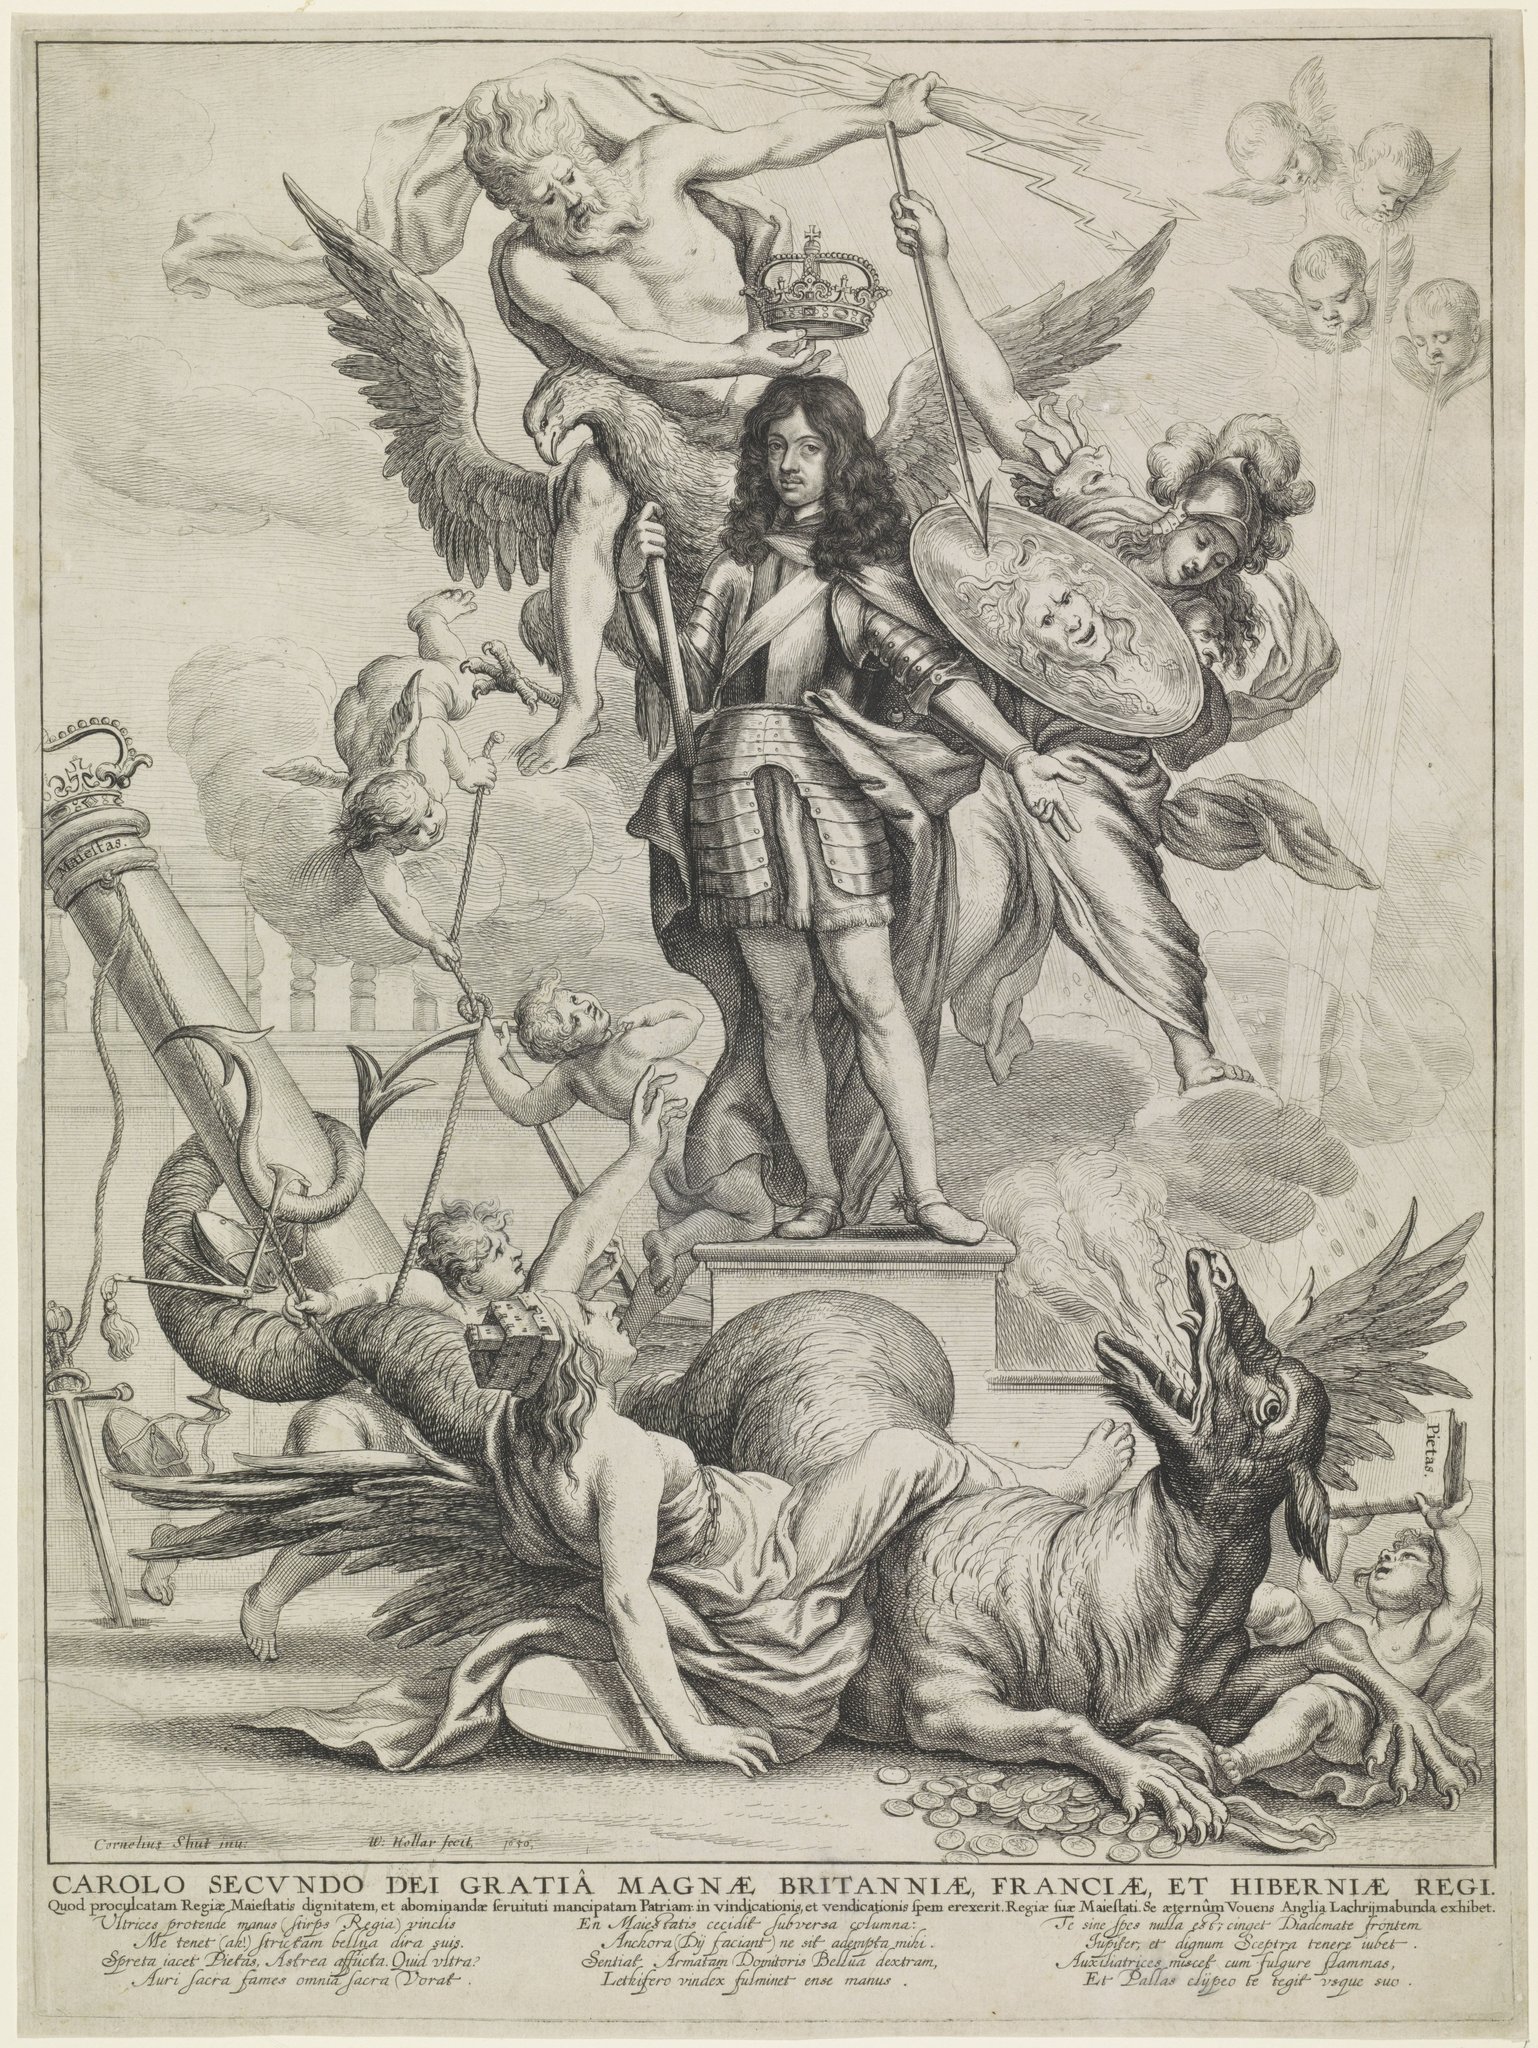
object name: print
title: Allegorie op koning Karel II van Engeland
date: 1650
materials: paper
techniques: engraving, etching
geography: antwerp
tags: london, karel ii (koning van engeland), (story of) minerva (pallas, athena), personification of a city, town-patron(ess), (story of) jupiter (zeus), dragon, ruler, sovereign, angels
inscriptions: collector's mark: Lugt 240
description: Allegorie op koning Karel II van Engeland. De koning staat op een voetstuk en wordt gekroond door Jupiter. Naast hem is Minerva verschenen. Op de grond een draak, vrouw met stedenkroon (Londen ?) en engelen.